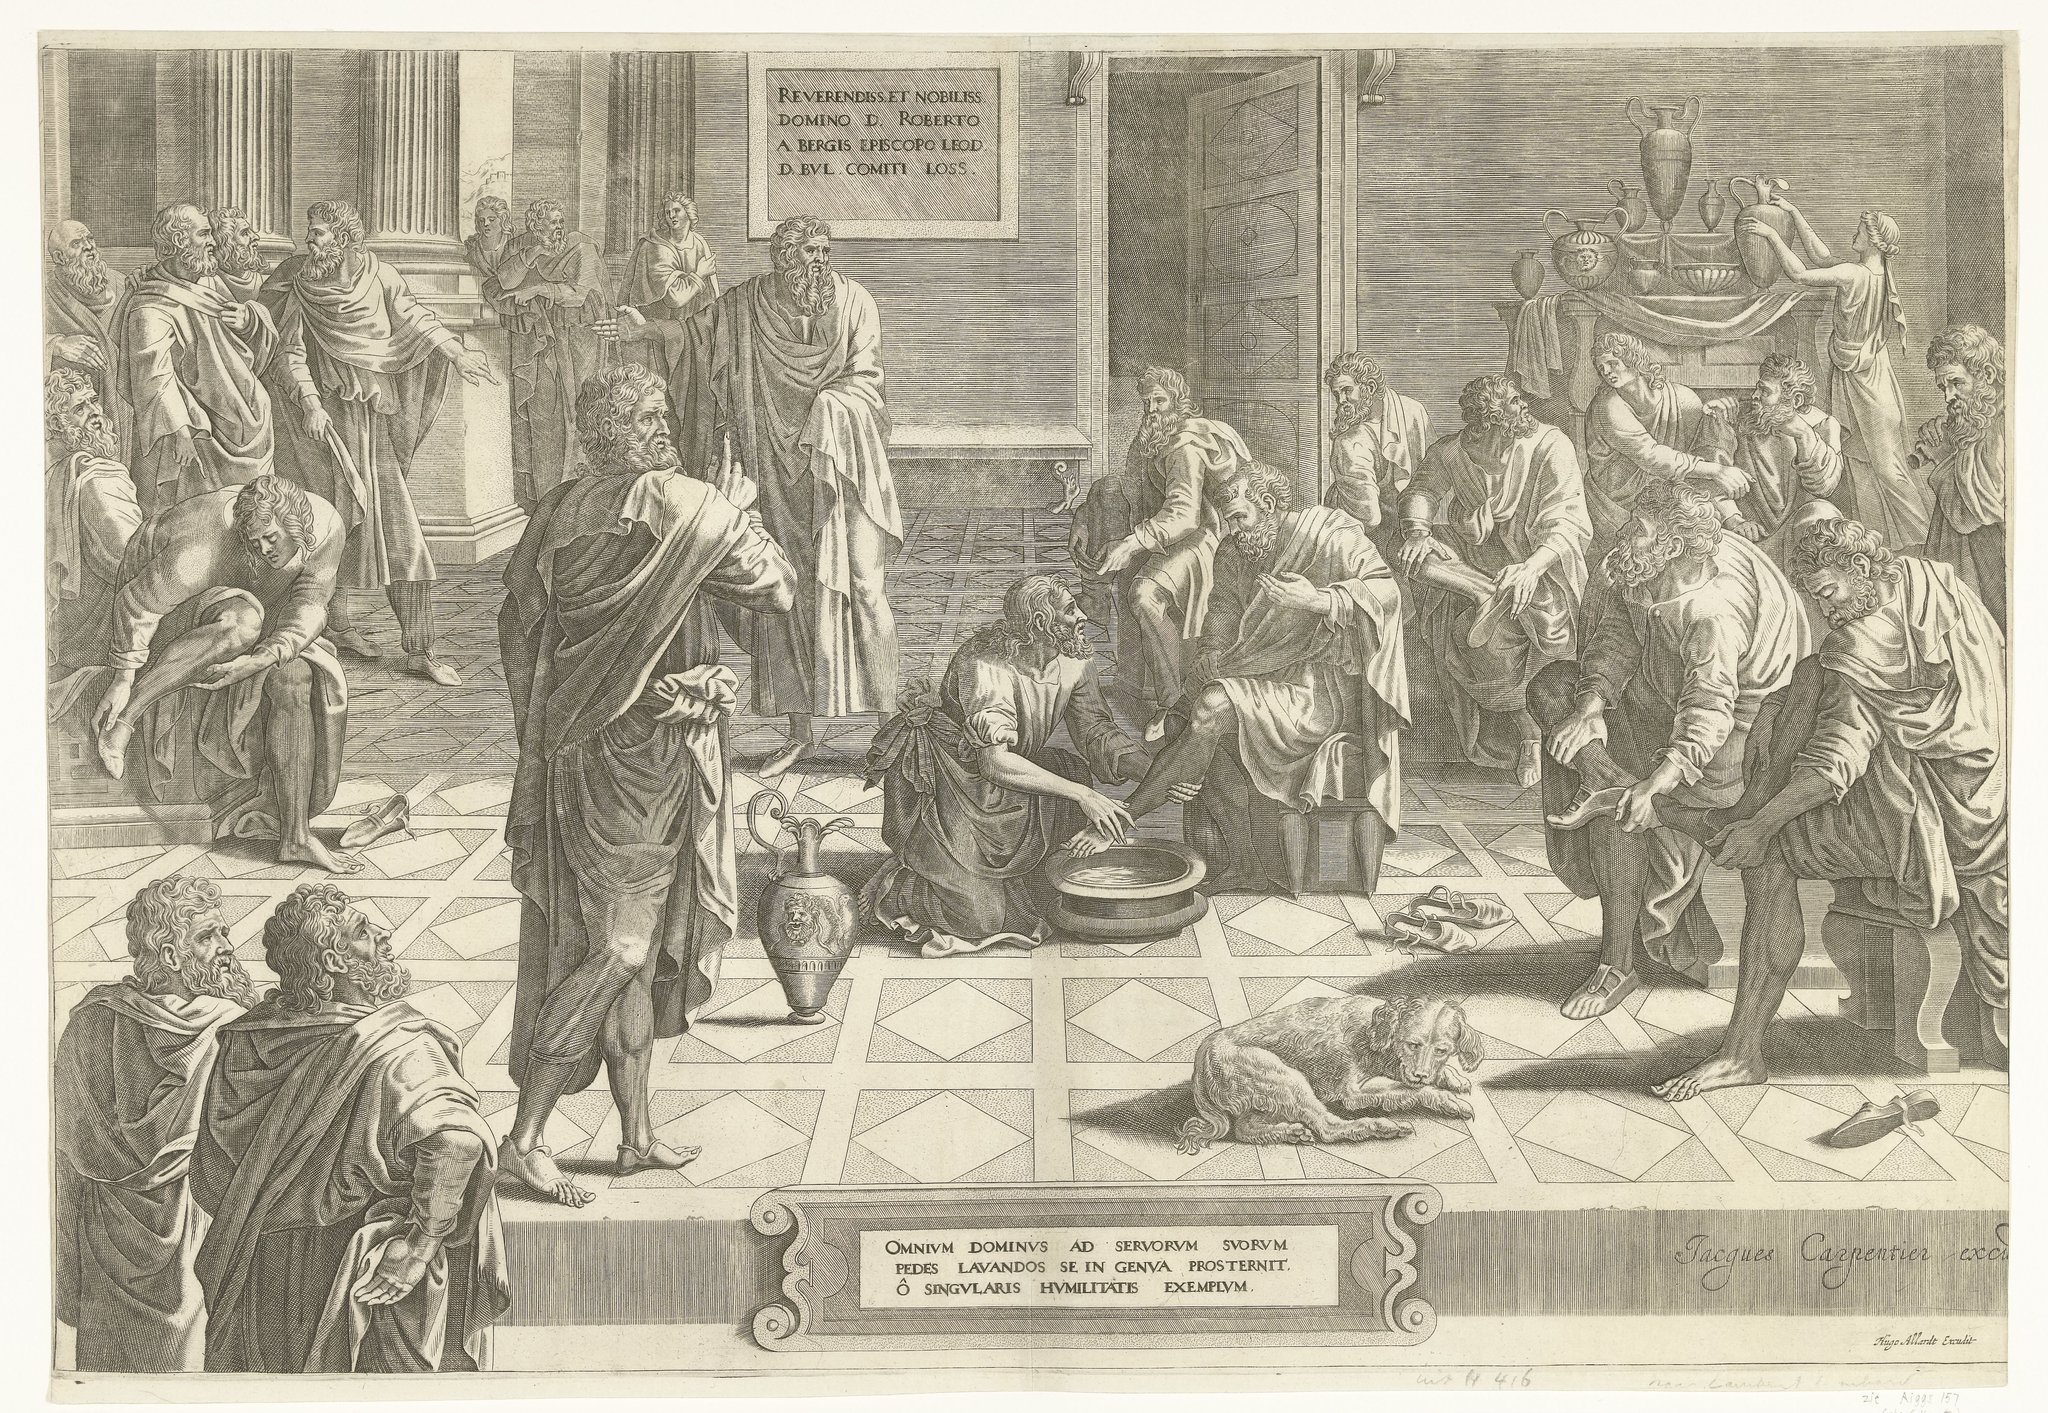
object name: print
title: Christus wast de voeten van de discipelen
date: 1640-1684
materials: paper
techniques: engraving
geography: amsterdam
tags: christ washes the feet of the apostles (john 13:1-20)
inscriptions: collector's mark: Lugt 2228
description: Christus wast zijn discipelen een voor een de voeten. De discipelen die nog niet aan de beurt waren zitten op banken en stoelen en trekken hun schoenen uit.